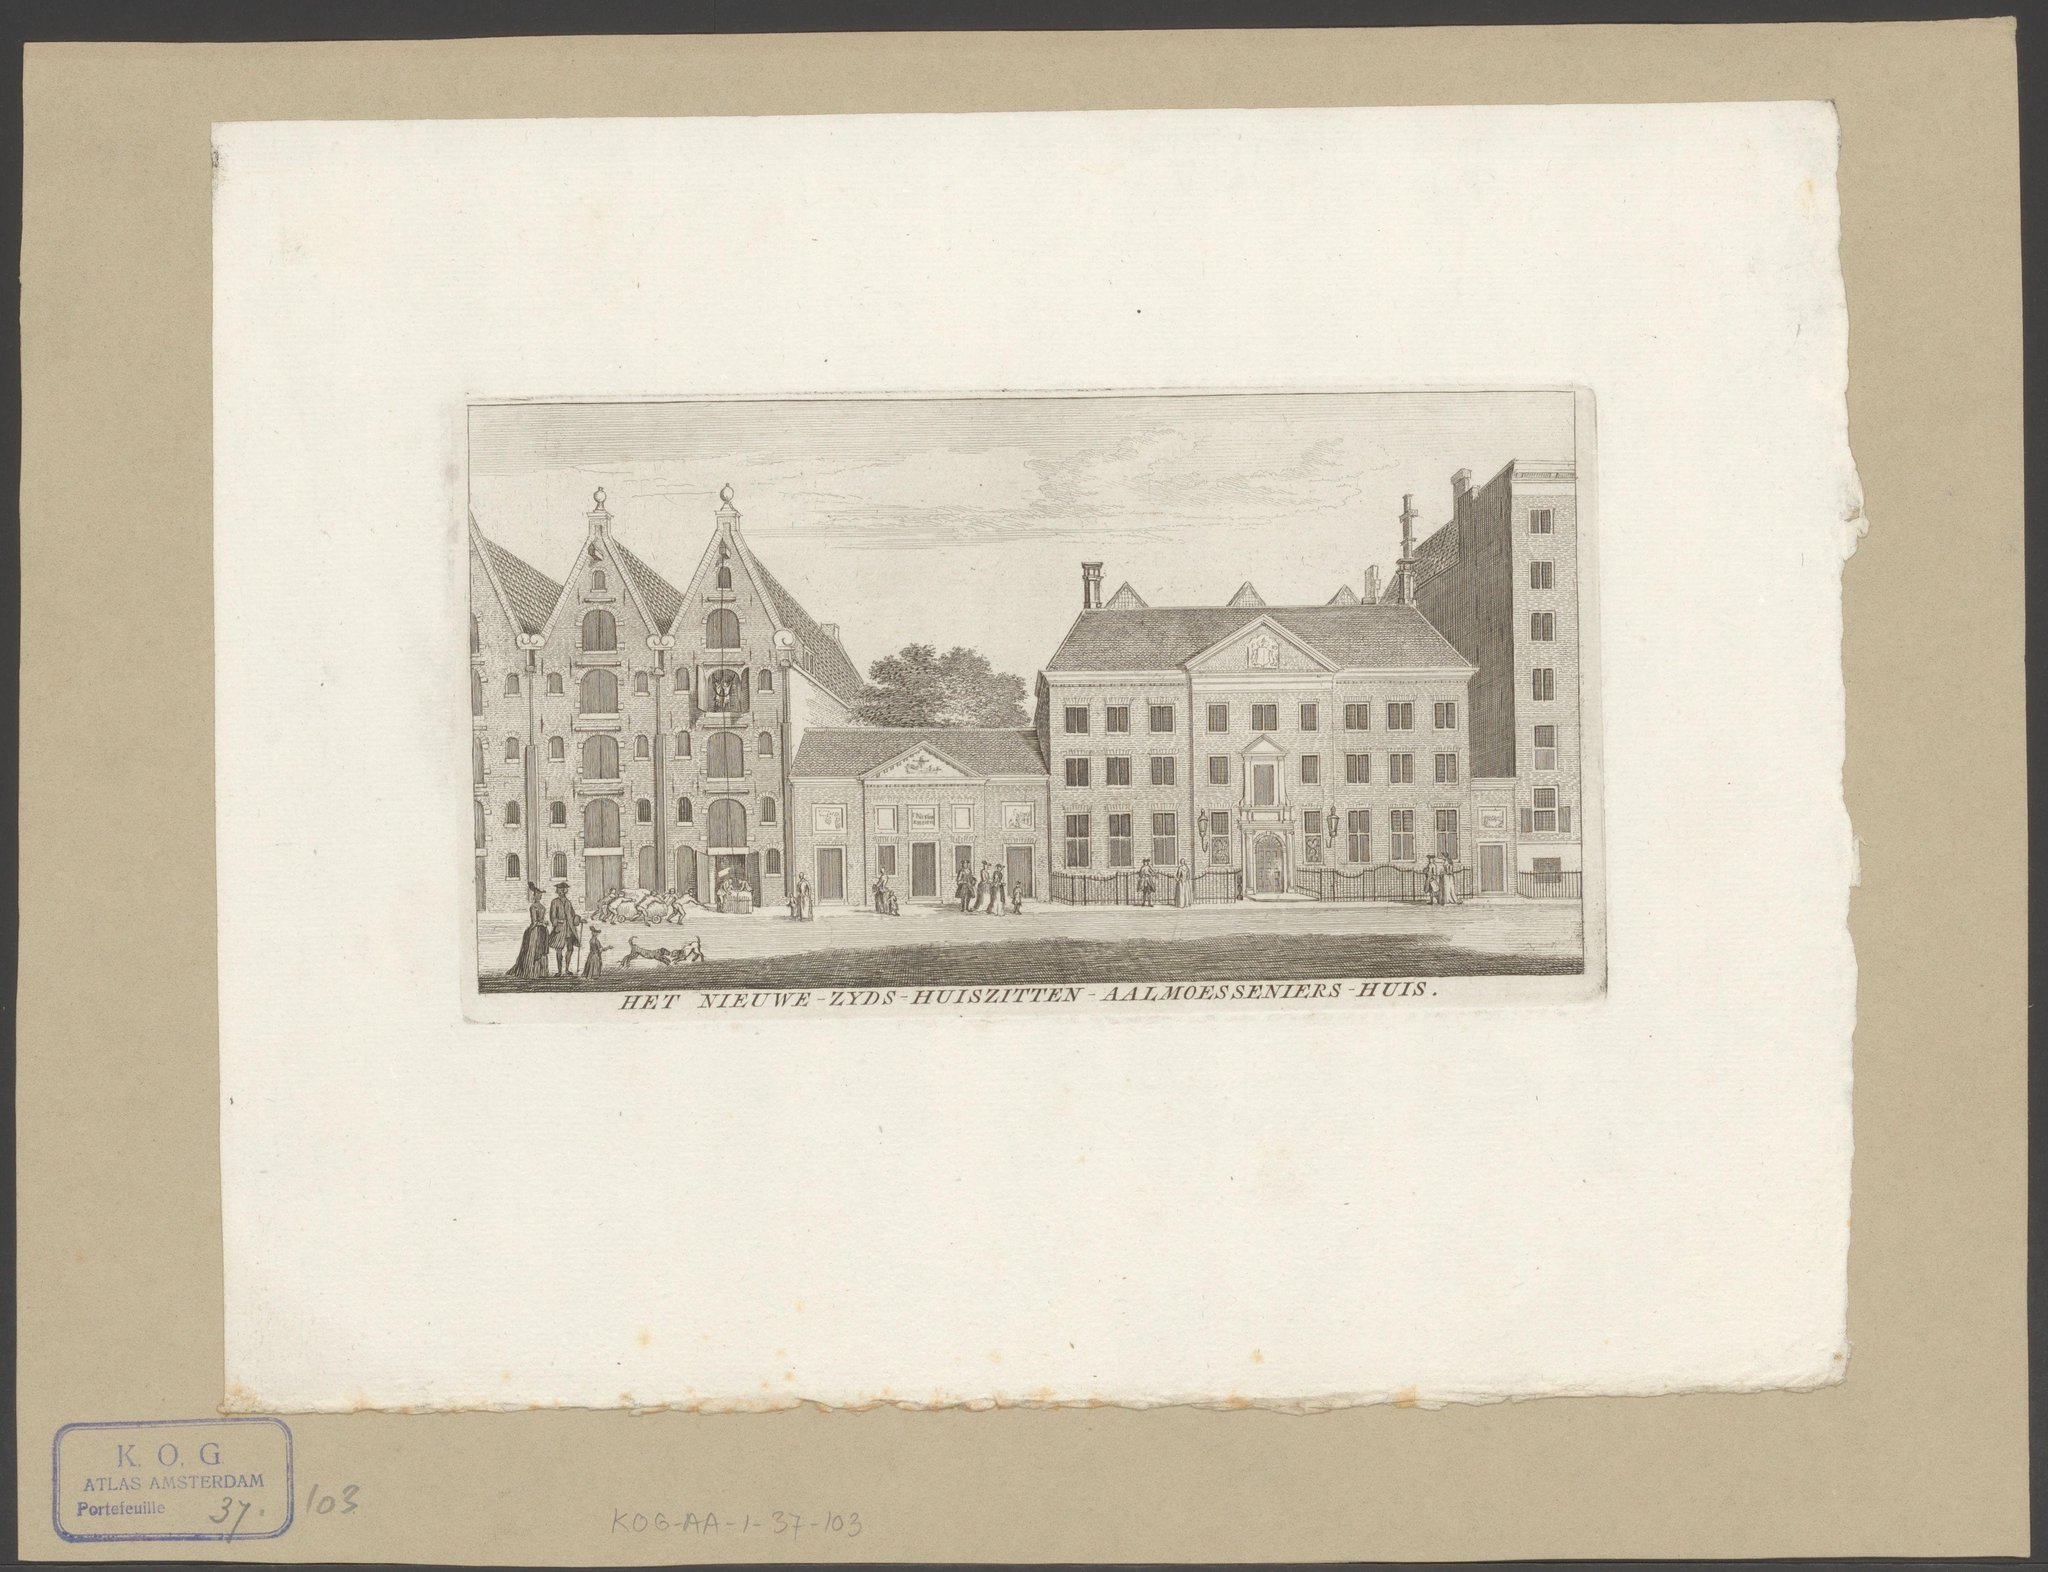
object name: print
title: Gezicht op het Nieuwezijds Huiszittenhuis te Amsterdam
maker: Anonymous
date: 1765-1782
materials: paper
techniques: engraving, etching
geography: northern netherlands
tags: poorhouse, street (+ city(-scape) with figures, staffage)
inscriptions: collector's mark: Lugt 1641b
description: Afdruk van de volledige plaat ook gebruikt in: Wagenaar, Jan. Amsterdam, in zyne opkomst, aanwas, geschiedenissen (…). Amsterdam: Isaak Tirion, 1765, dl. 2. En in: Verzameling der fraaiste gezigten van Amsterdam in negen en zeventig afbeeldingen. Amsterdam en Harlingen: Petrus Conradi en Volkert van der Plaats, 1782. Zie KOG-AA-1-37-99.